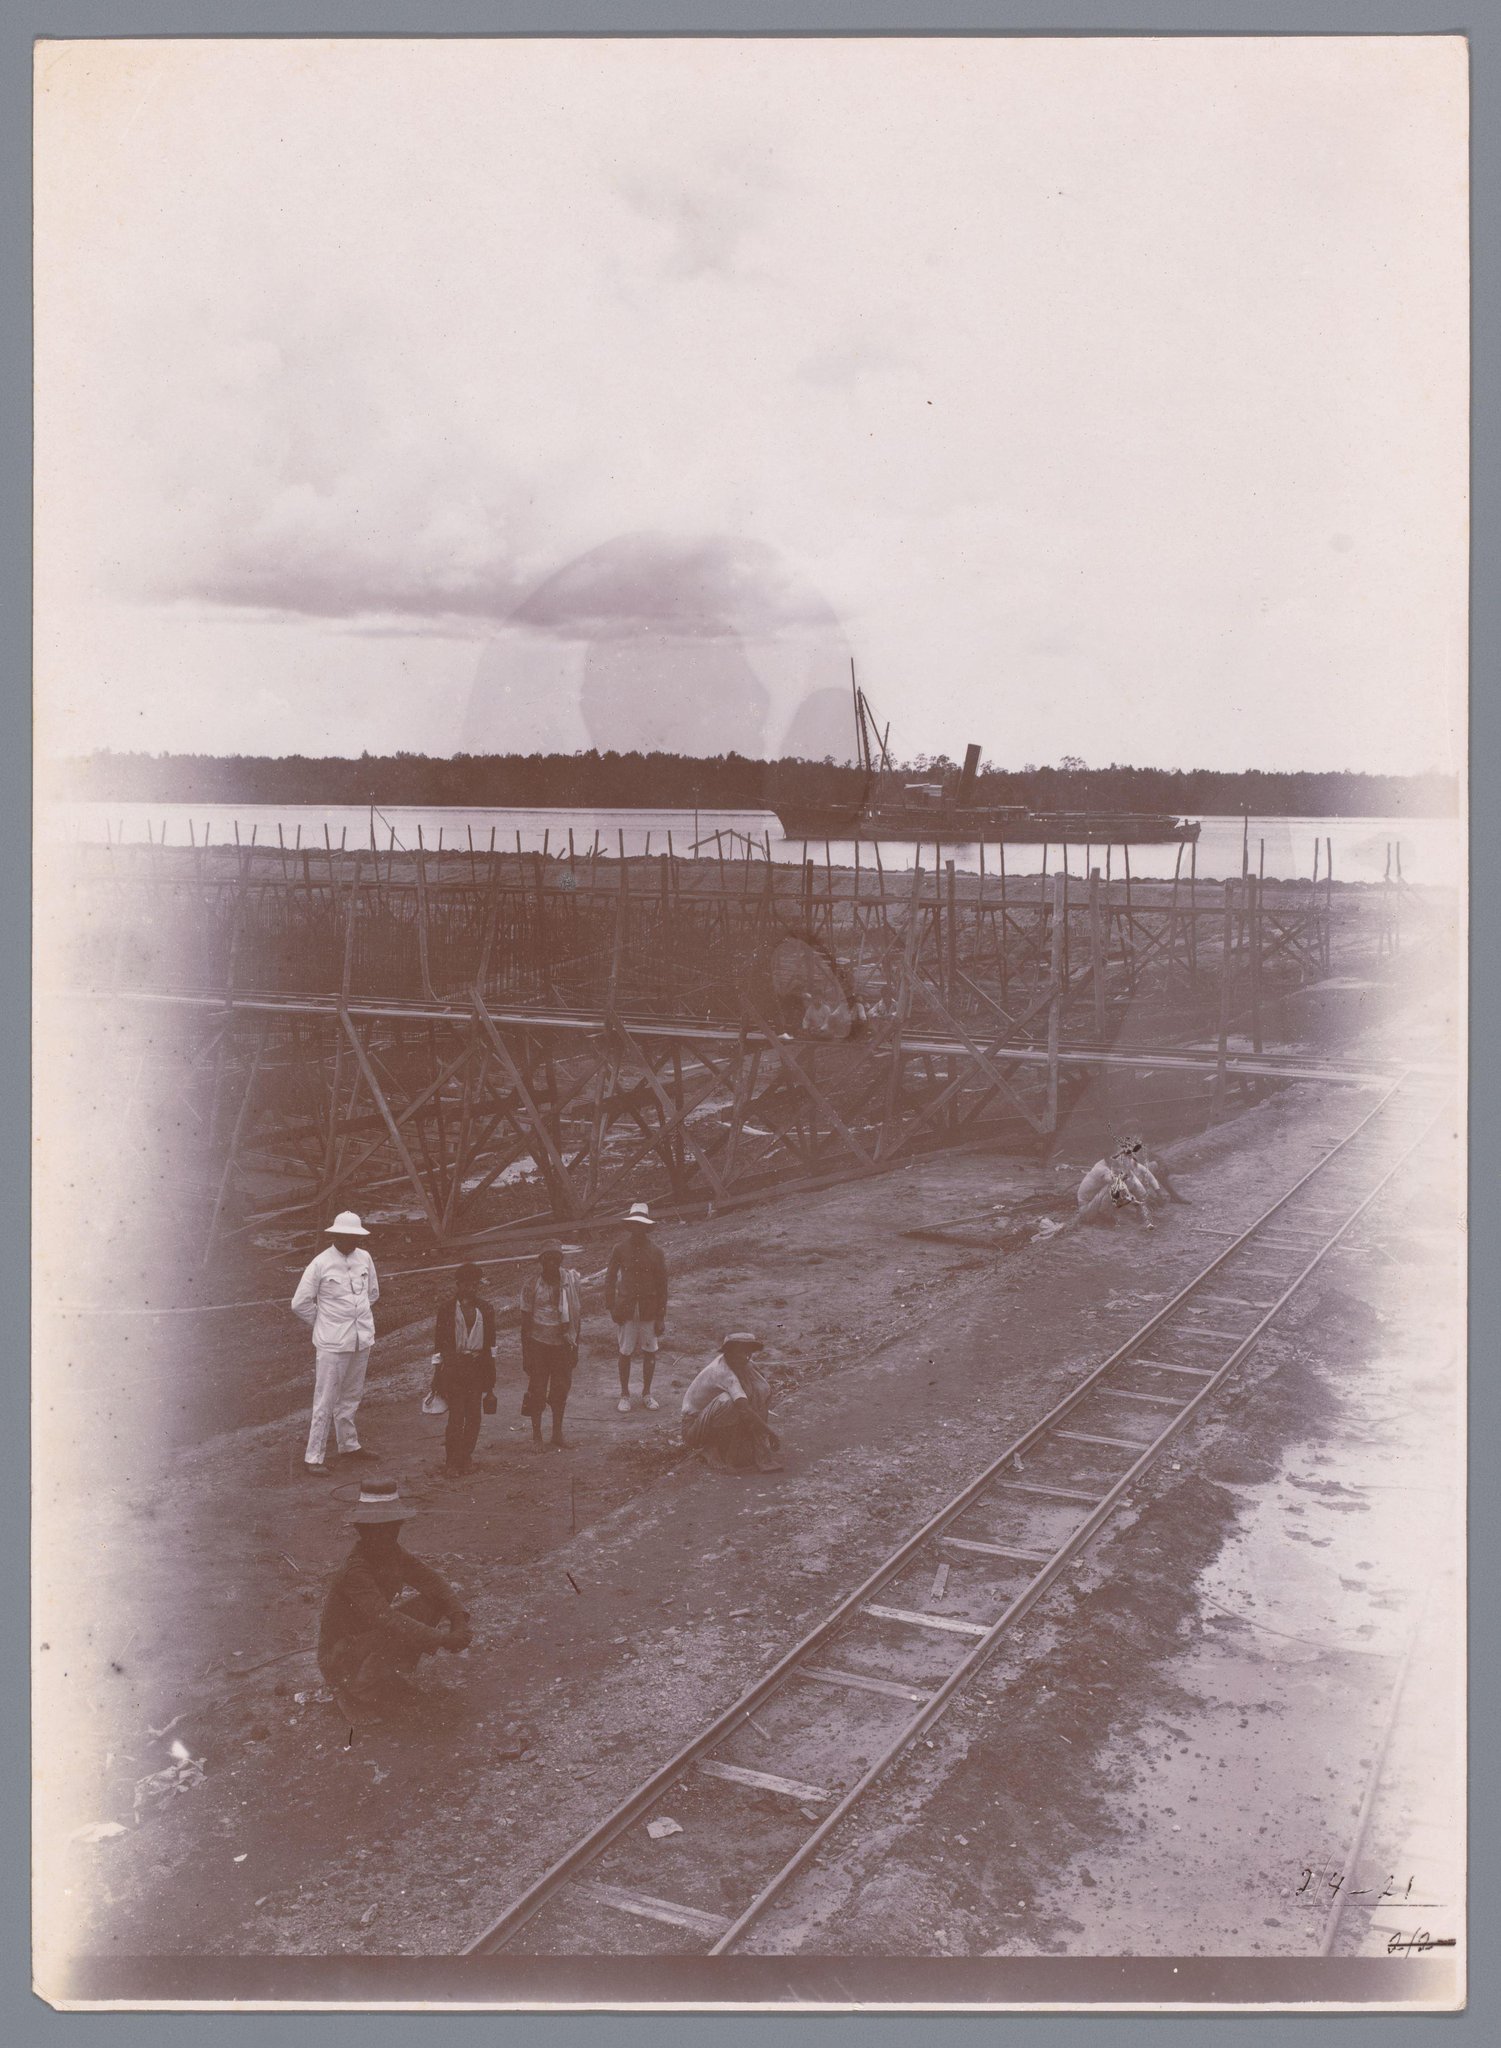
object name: photograph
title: Overzicht gedeelte bouwput en 9e caisson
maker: Anonymous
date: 1921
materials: photographic support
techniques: gelatin silver print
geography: belawan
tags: harbour, railway, tramway; rack railway, building-site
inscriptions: date: ‘2/4-21’, inscription: ‘No. 14. Overzicht gedeelte bouwput en 9e caisson’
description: Bouwterrein met opzichter en arbeiders, rechts een spoor. Genummerd: 14. Onderdeel van de groep van losse foto's over de aanleg van de haven Belawan aan de kust voor Medan, Sumatra 1921-1922.